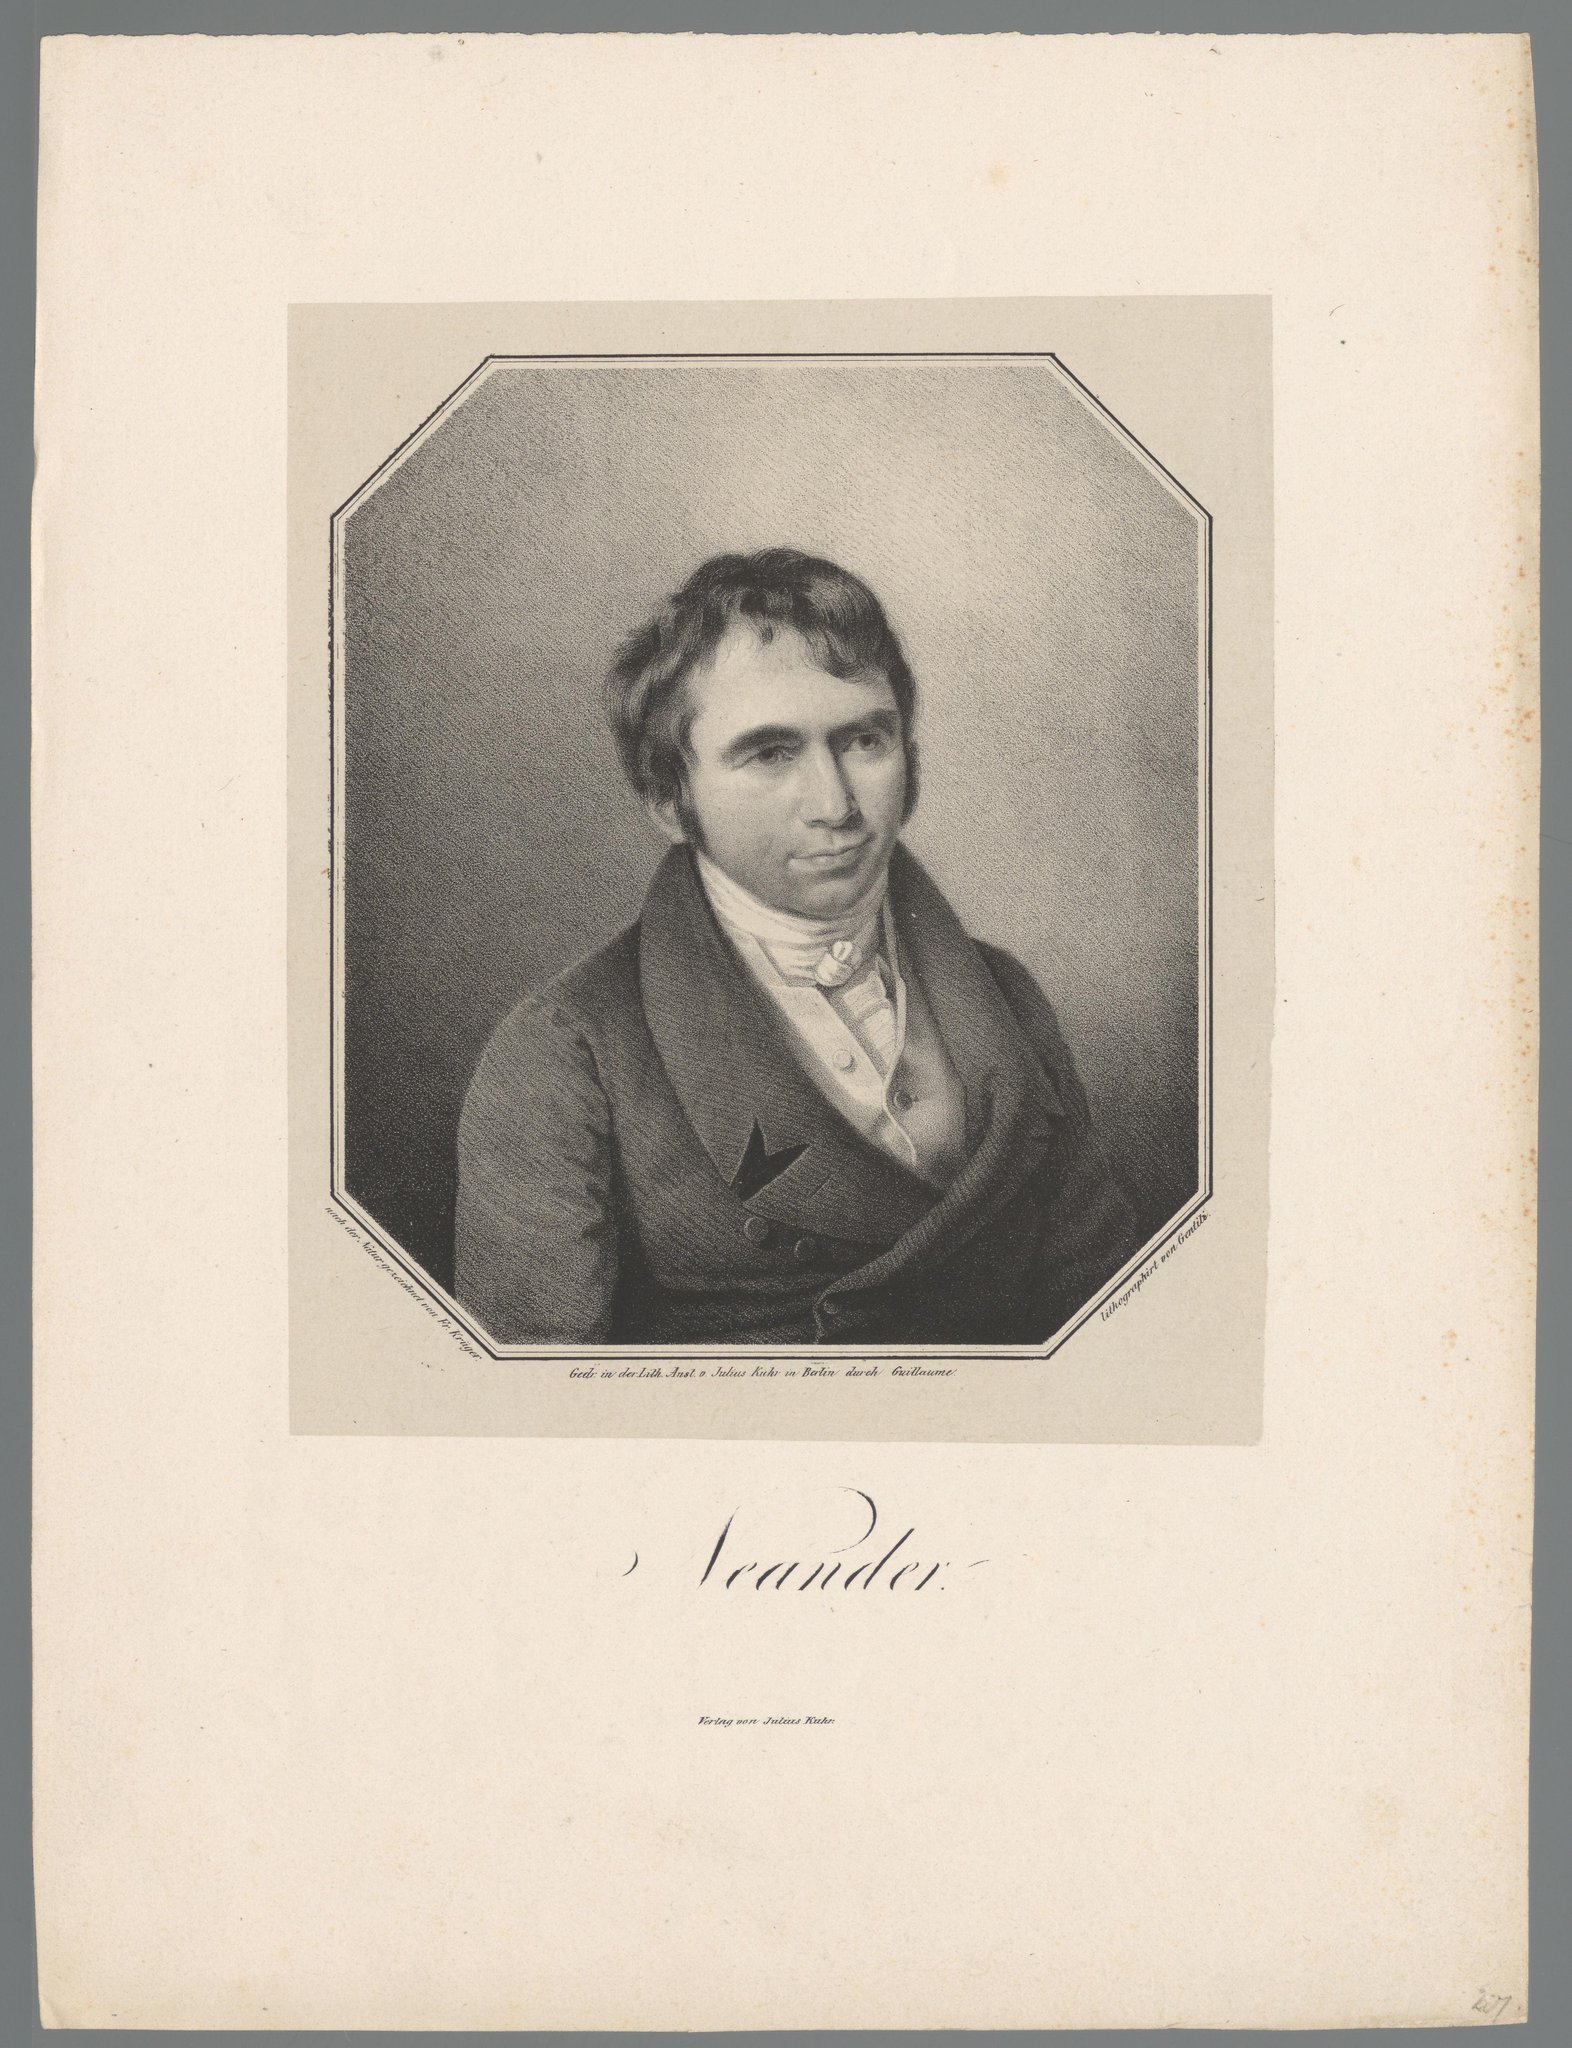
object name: print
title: Neander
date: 1820-1840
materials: paper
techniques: lithograph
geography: berlin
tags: berlin, theologian, historical persons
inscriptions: collector's mark: Lugt 2228